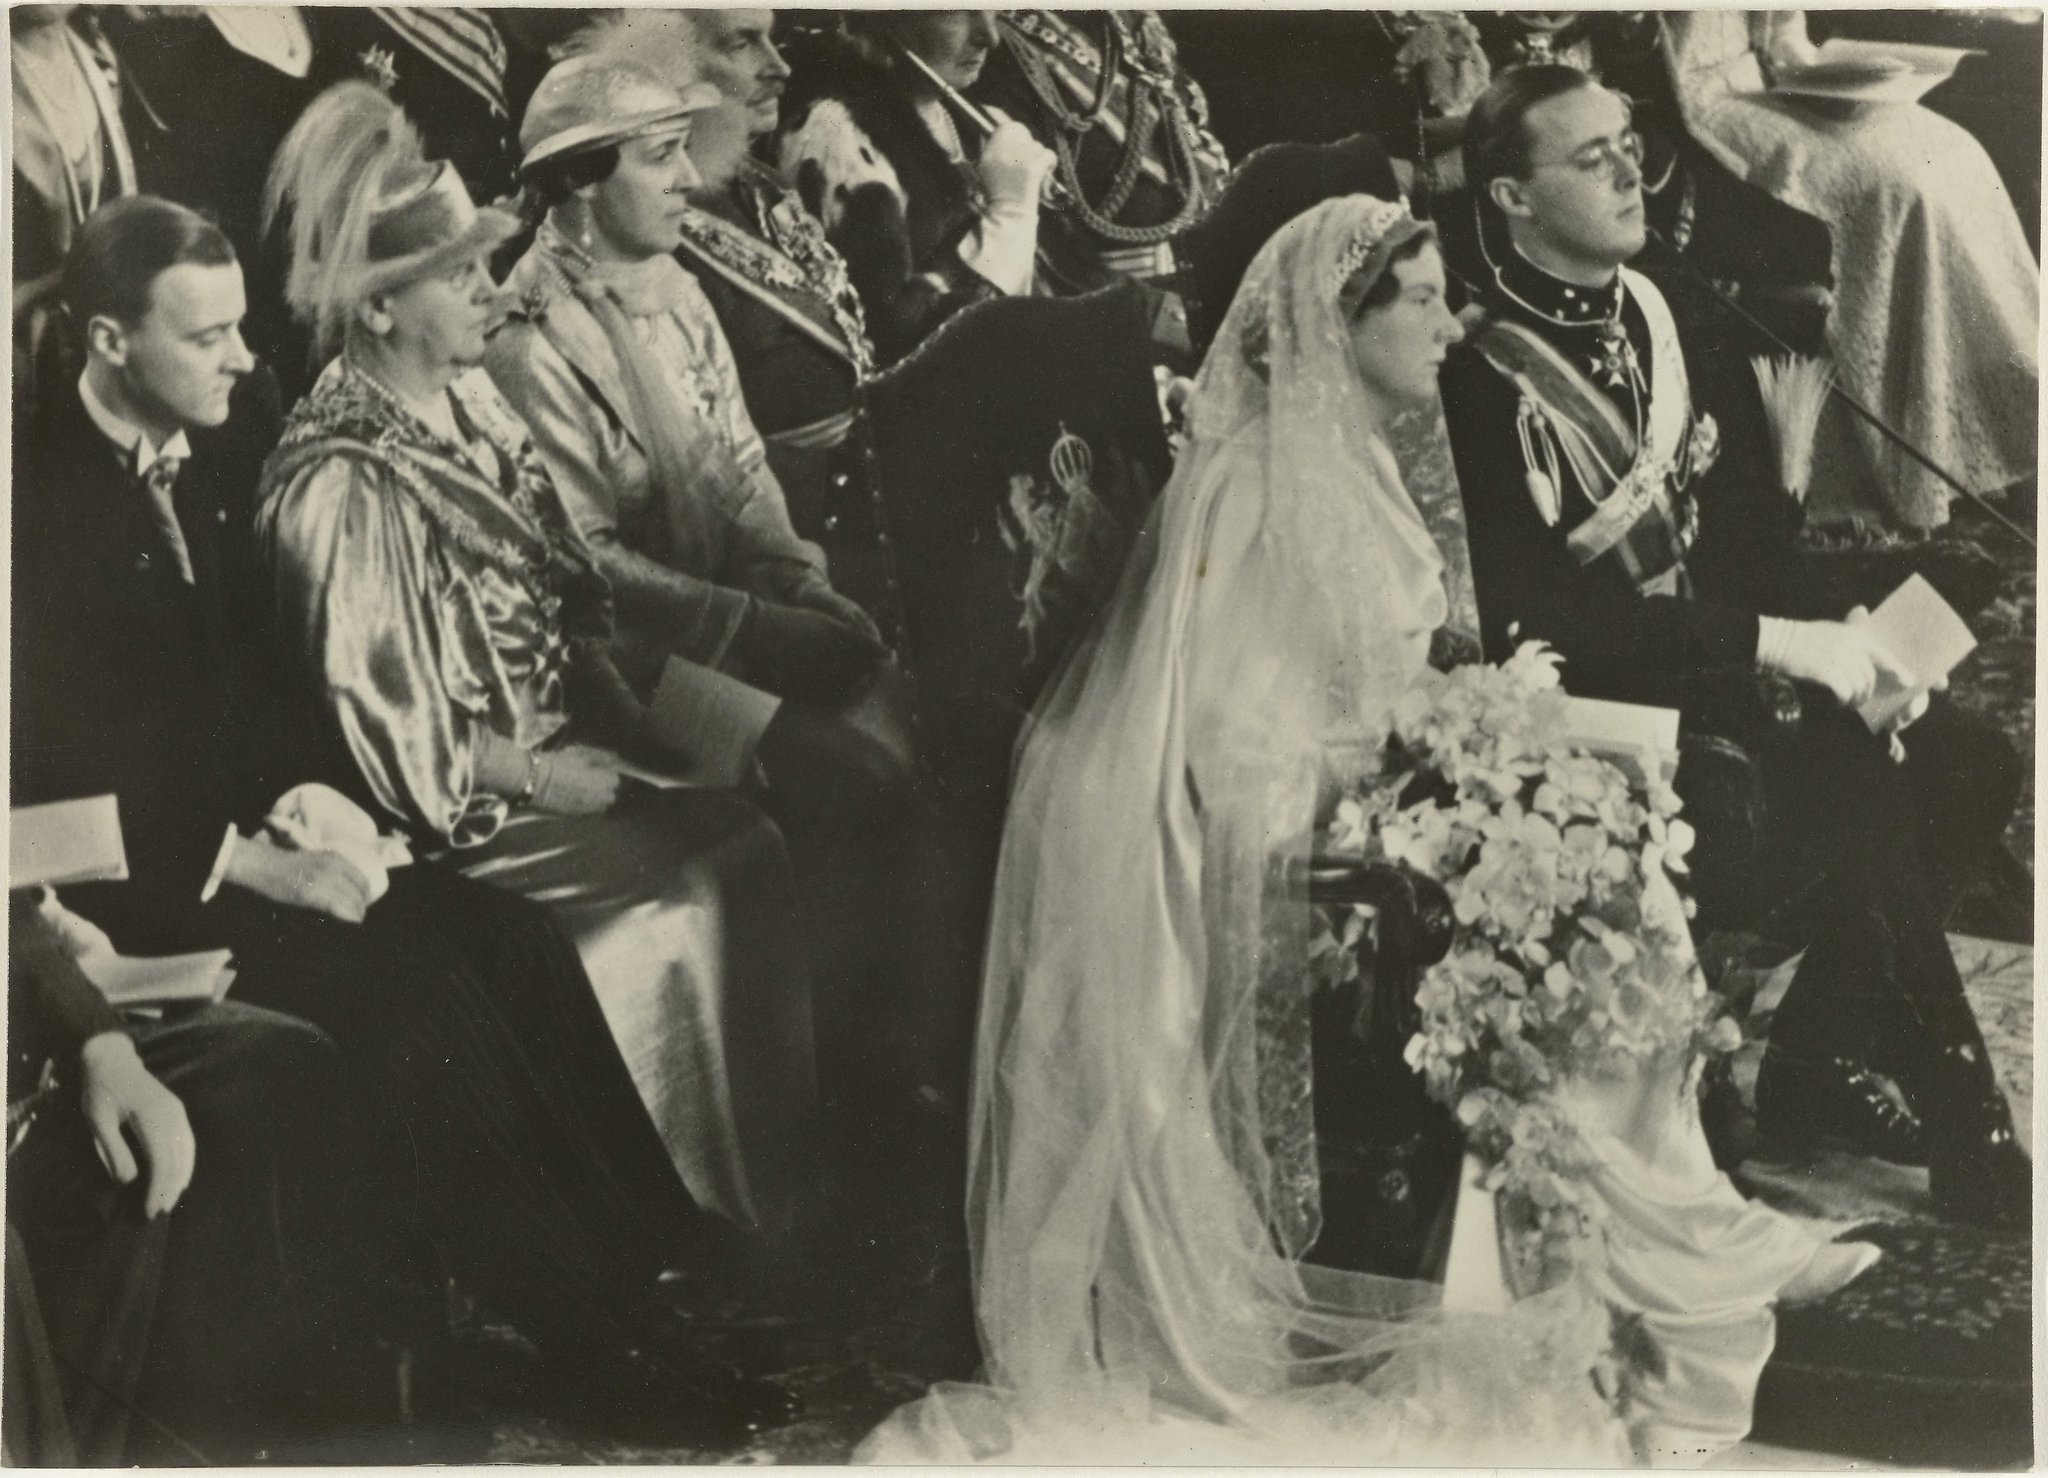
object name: photograph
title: Inzegening van het huwelijk van prinses Juliana en prins Bernhard in de St. Jacobskerk in Den Haag, 7 januari 1937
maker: erich salomon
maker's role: fotograaf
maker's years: 1886-1944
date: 1937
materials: paper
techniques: gelatin silver print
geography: the hague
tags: utrecht, bernhard (prins der nederlanden), juliana of the netherlands, marriage ~ protestant service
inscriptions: annotation: ‘DE INZEGENING // van // HET HUWELIJK // van Hunne Koninklijke Hoogheden // PRINSES JULIANA EN PRINS BERNHARD // in de St. Jacobskerk te 's Gravenhage // 7 Januari 1937 // UITGAVE VAN WEEKBLAD "HET LEVEN" // Copyright Dr. Erich Salomon’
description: Eén van 10 prentbriefkaarten in een mapje.